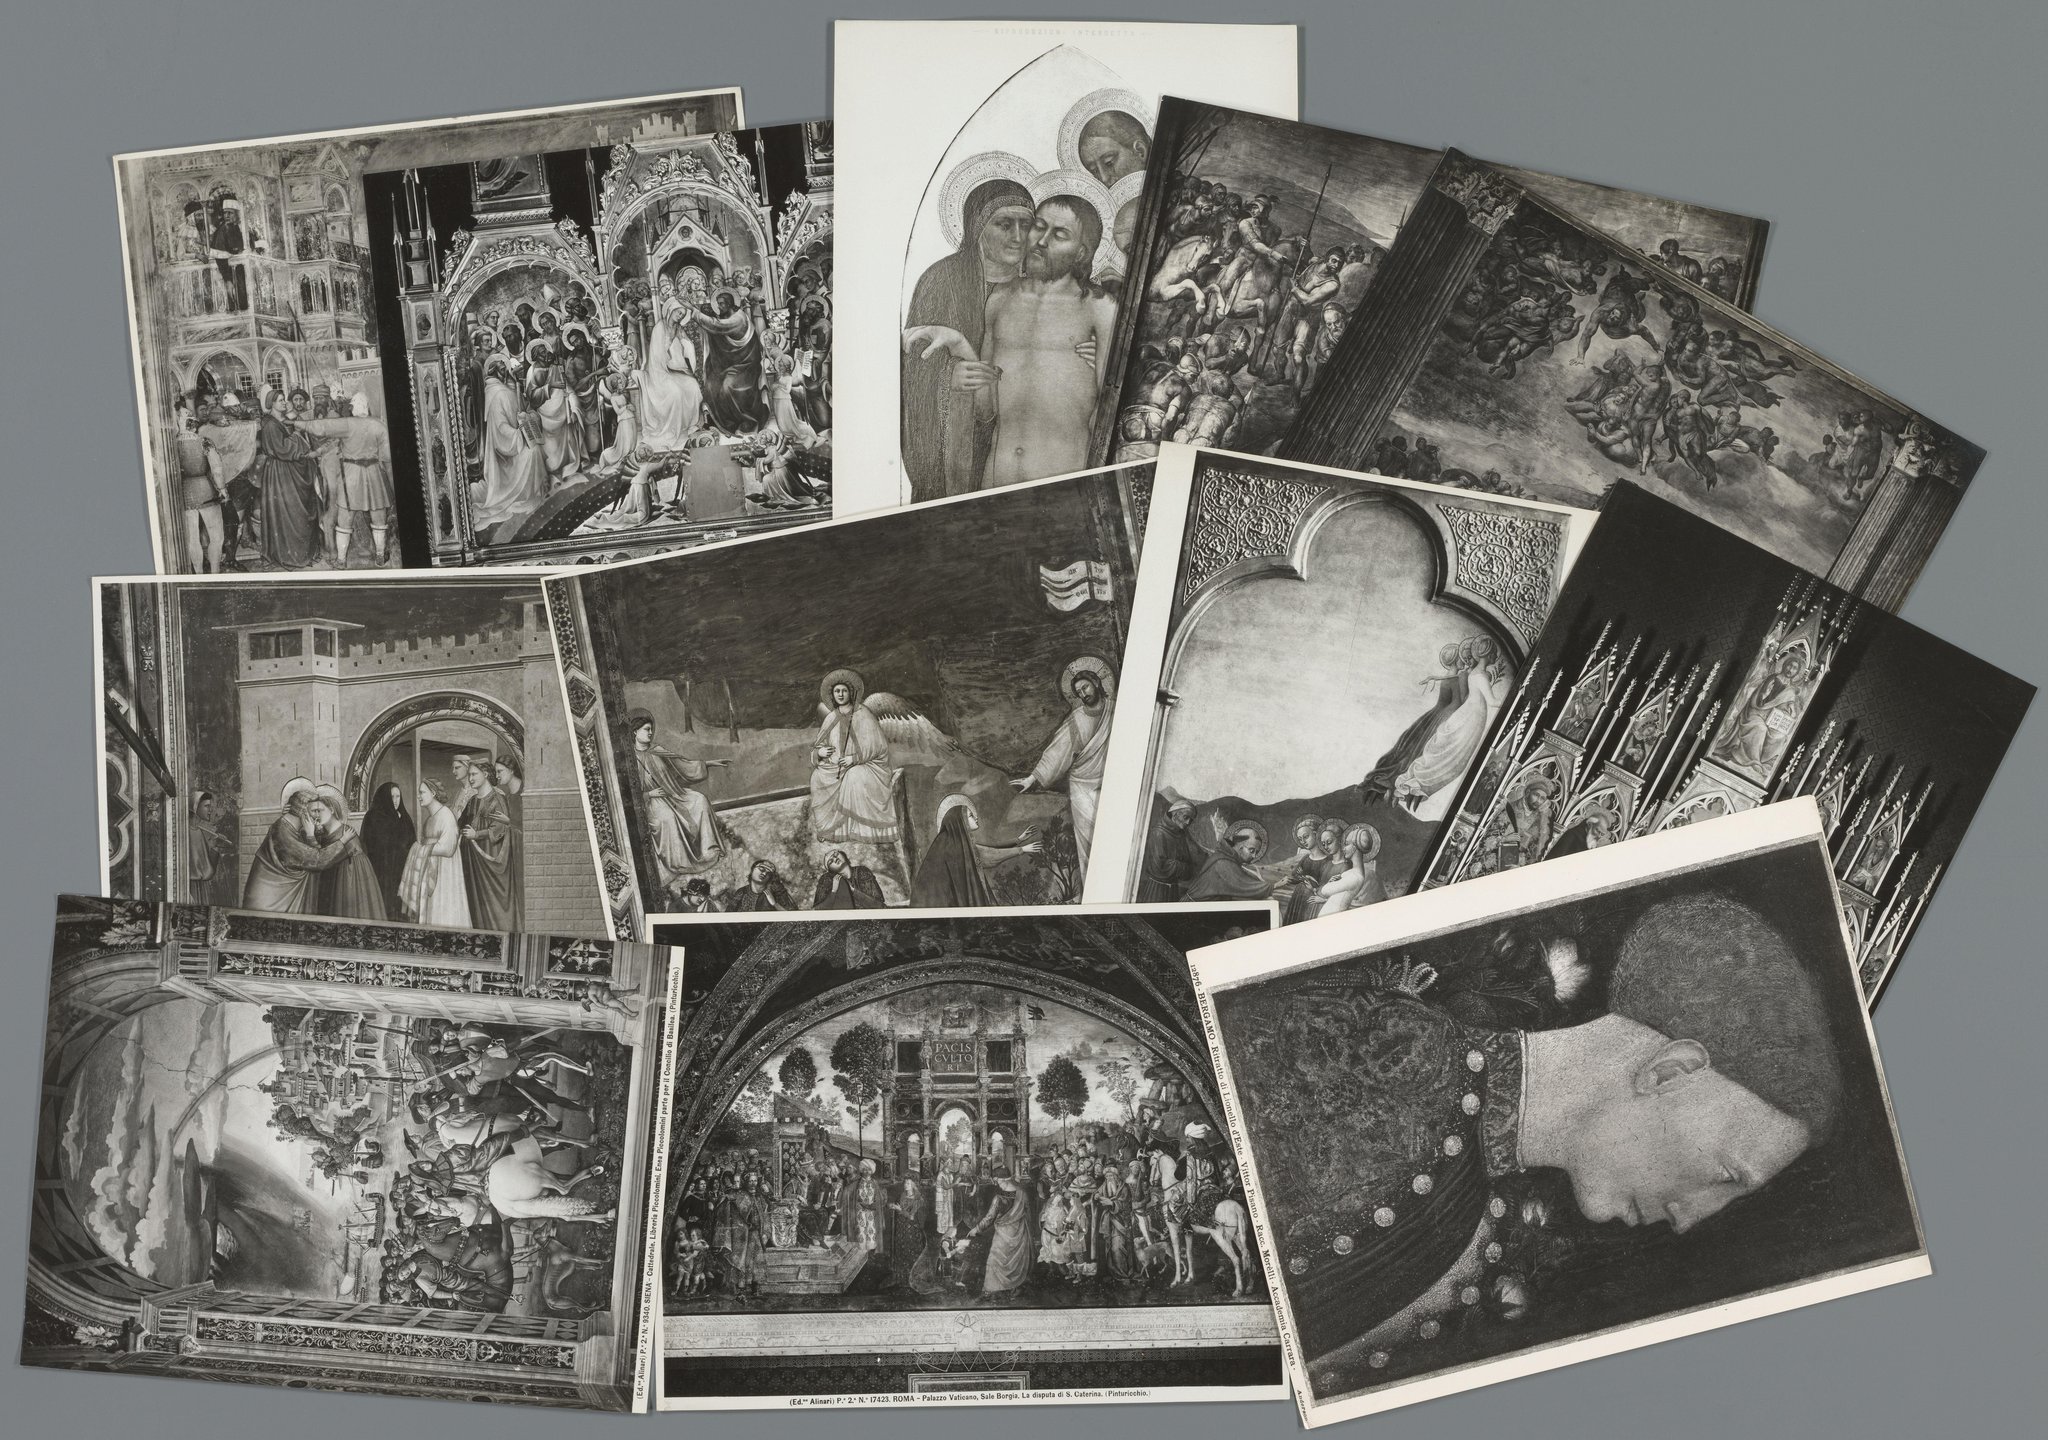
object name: reproduction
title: Fotocollectie van Arthur François Emile van Schendel jr.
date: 1910-1950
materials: paper, pencil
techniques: gelatin silver print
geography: italy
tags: picture, painting, italy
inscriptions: collector's mark: ‘AFE v S’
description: De collectie bevat 208 foto's met reproducties van kunstwerken, voornamelijk uit de Italiaanse renaissance. Vrijwel alle foto's zijn gemaakt door de Fratelli Alinari en uitgegeven door H.J.W. Becht. De meeste objecten dragen het stempel van Van Schendel ('AFE v S') en enkele hebben handgeschreven notities op verso.